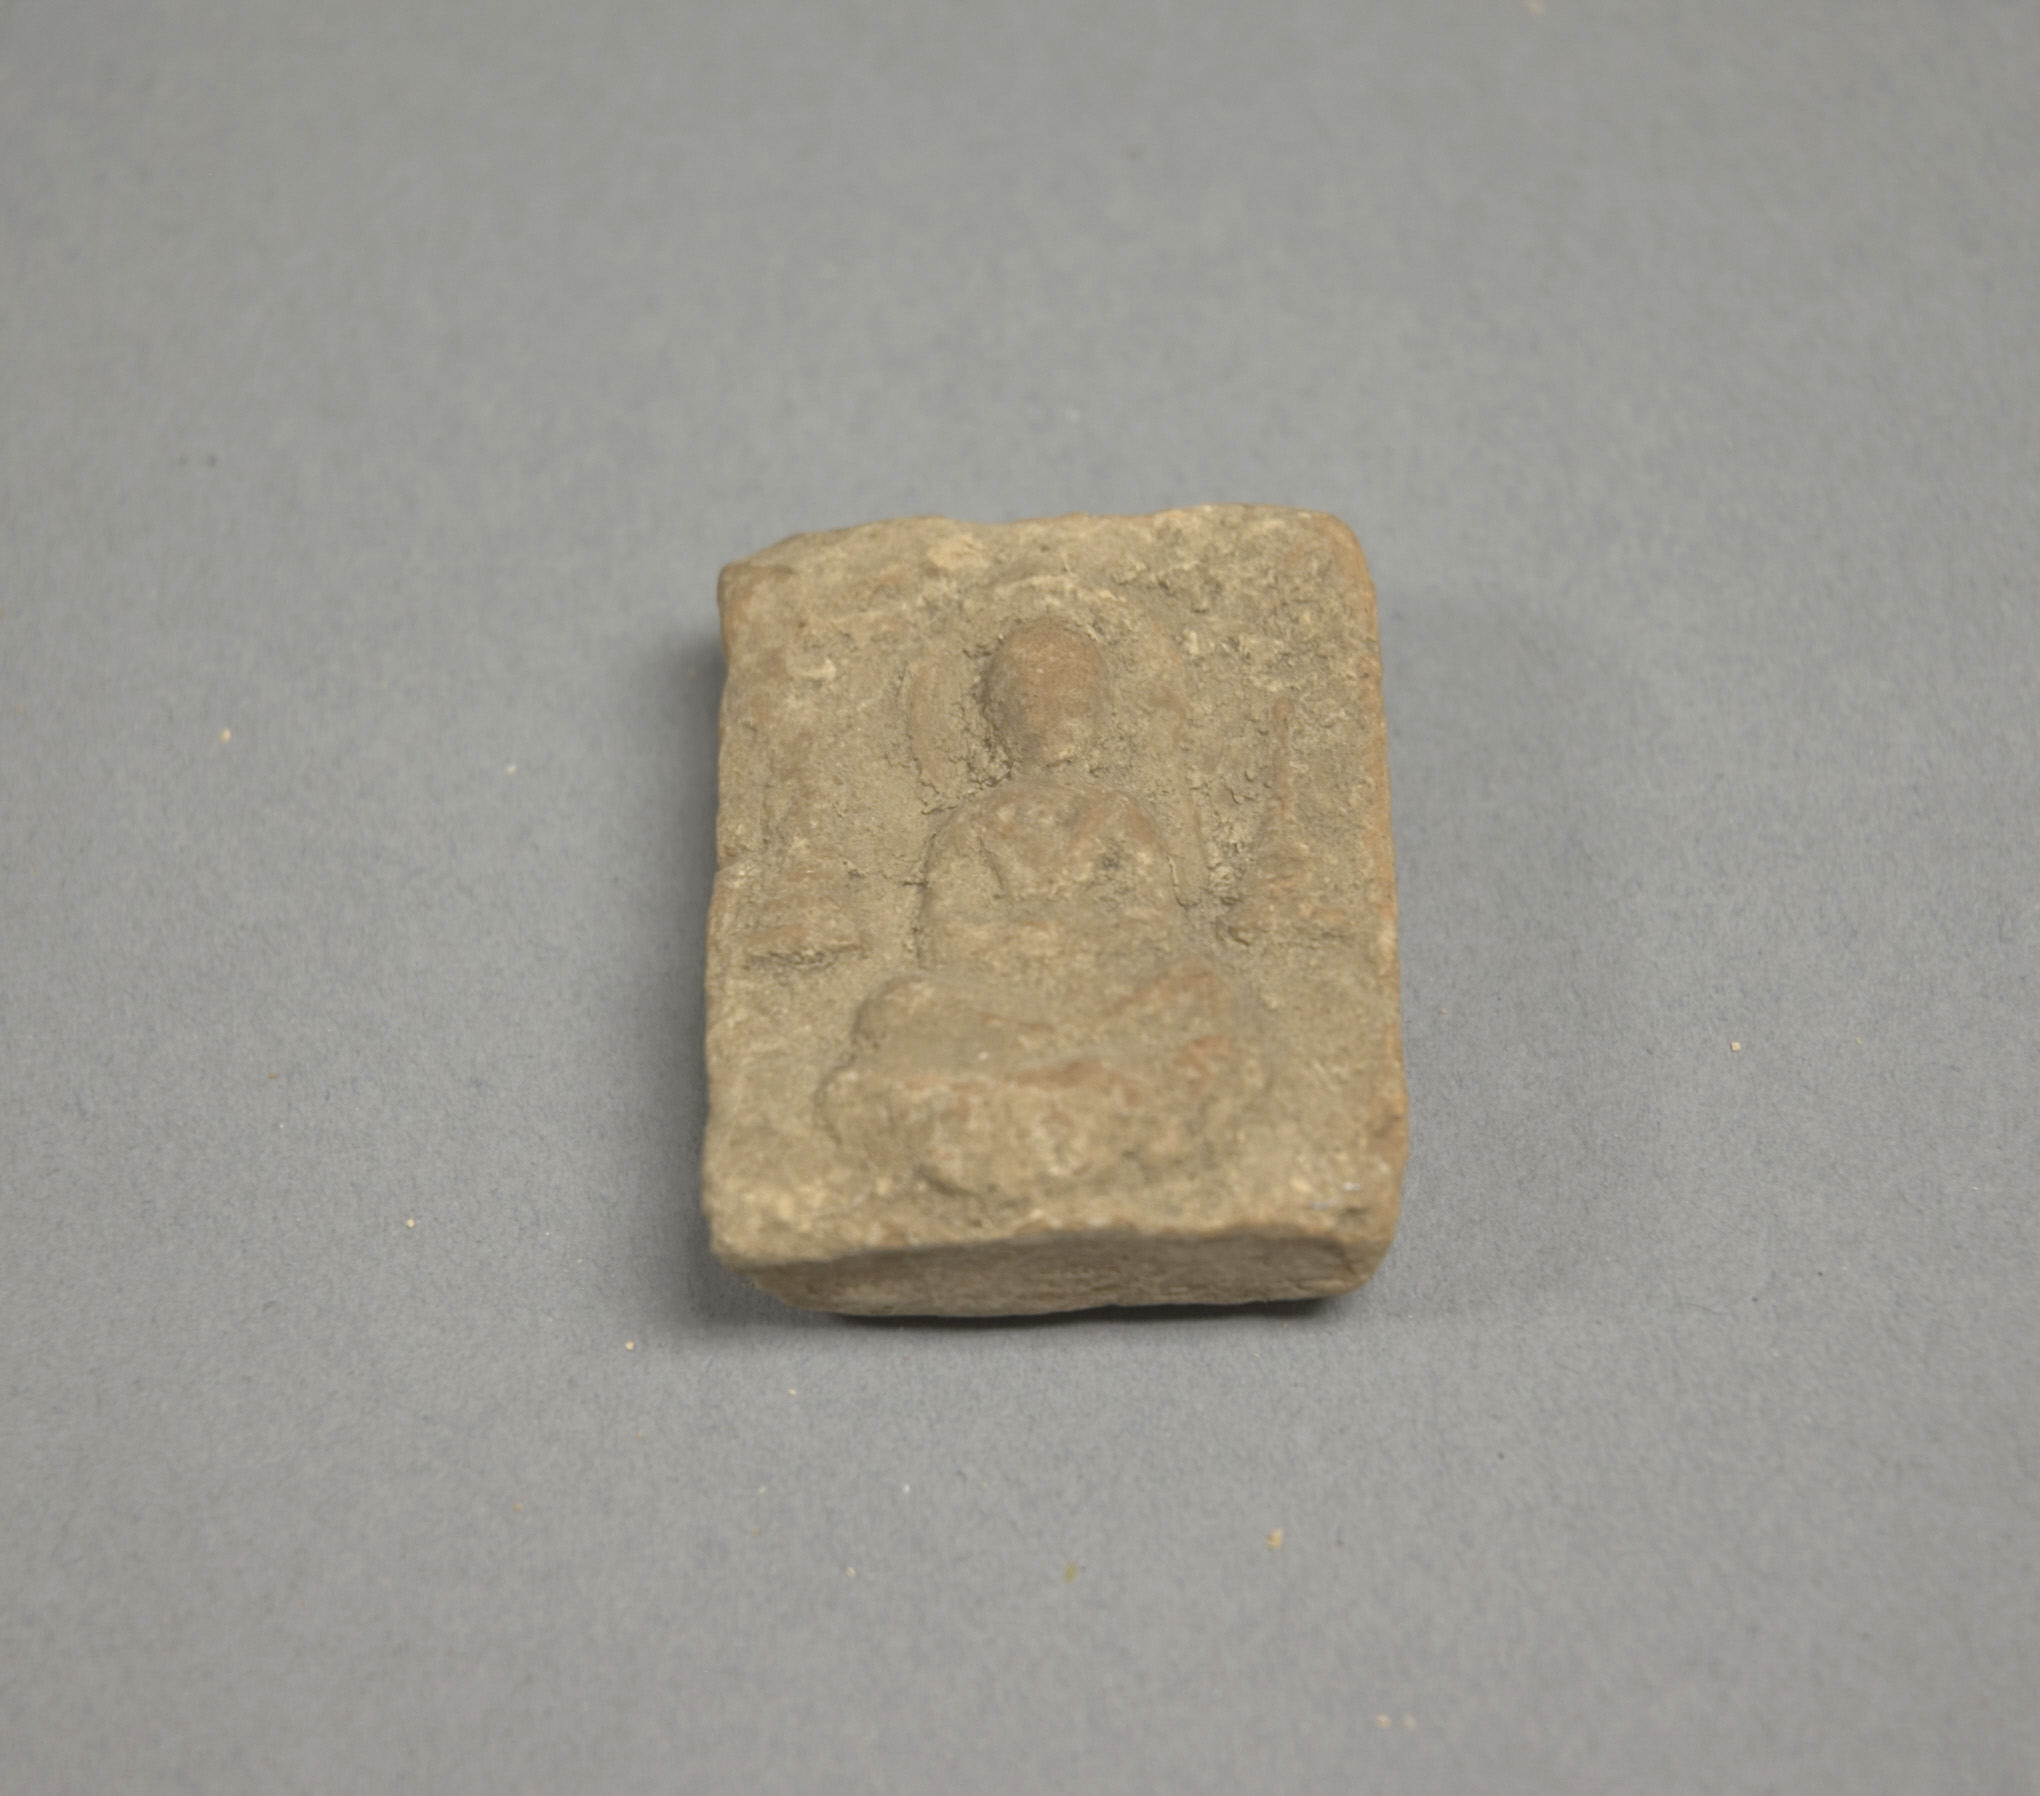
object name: plaque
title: Votive Plaque with Seated Buddhas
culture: tibetan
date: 618-906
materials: terracotta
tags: buddha